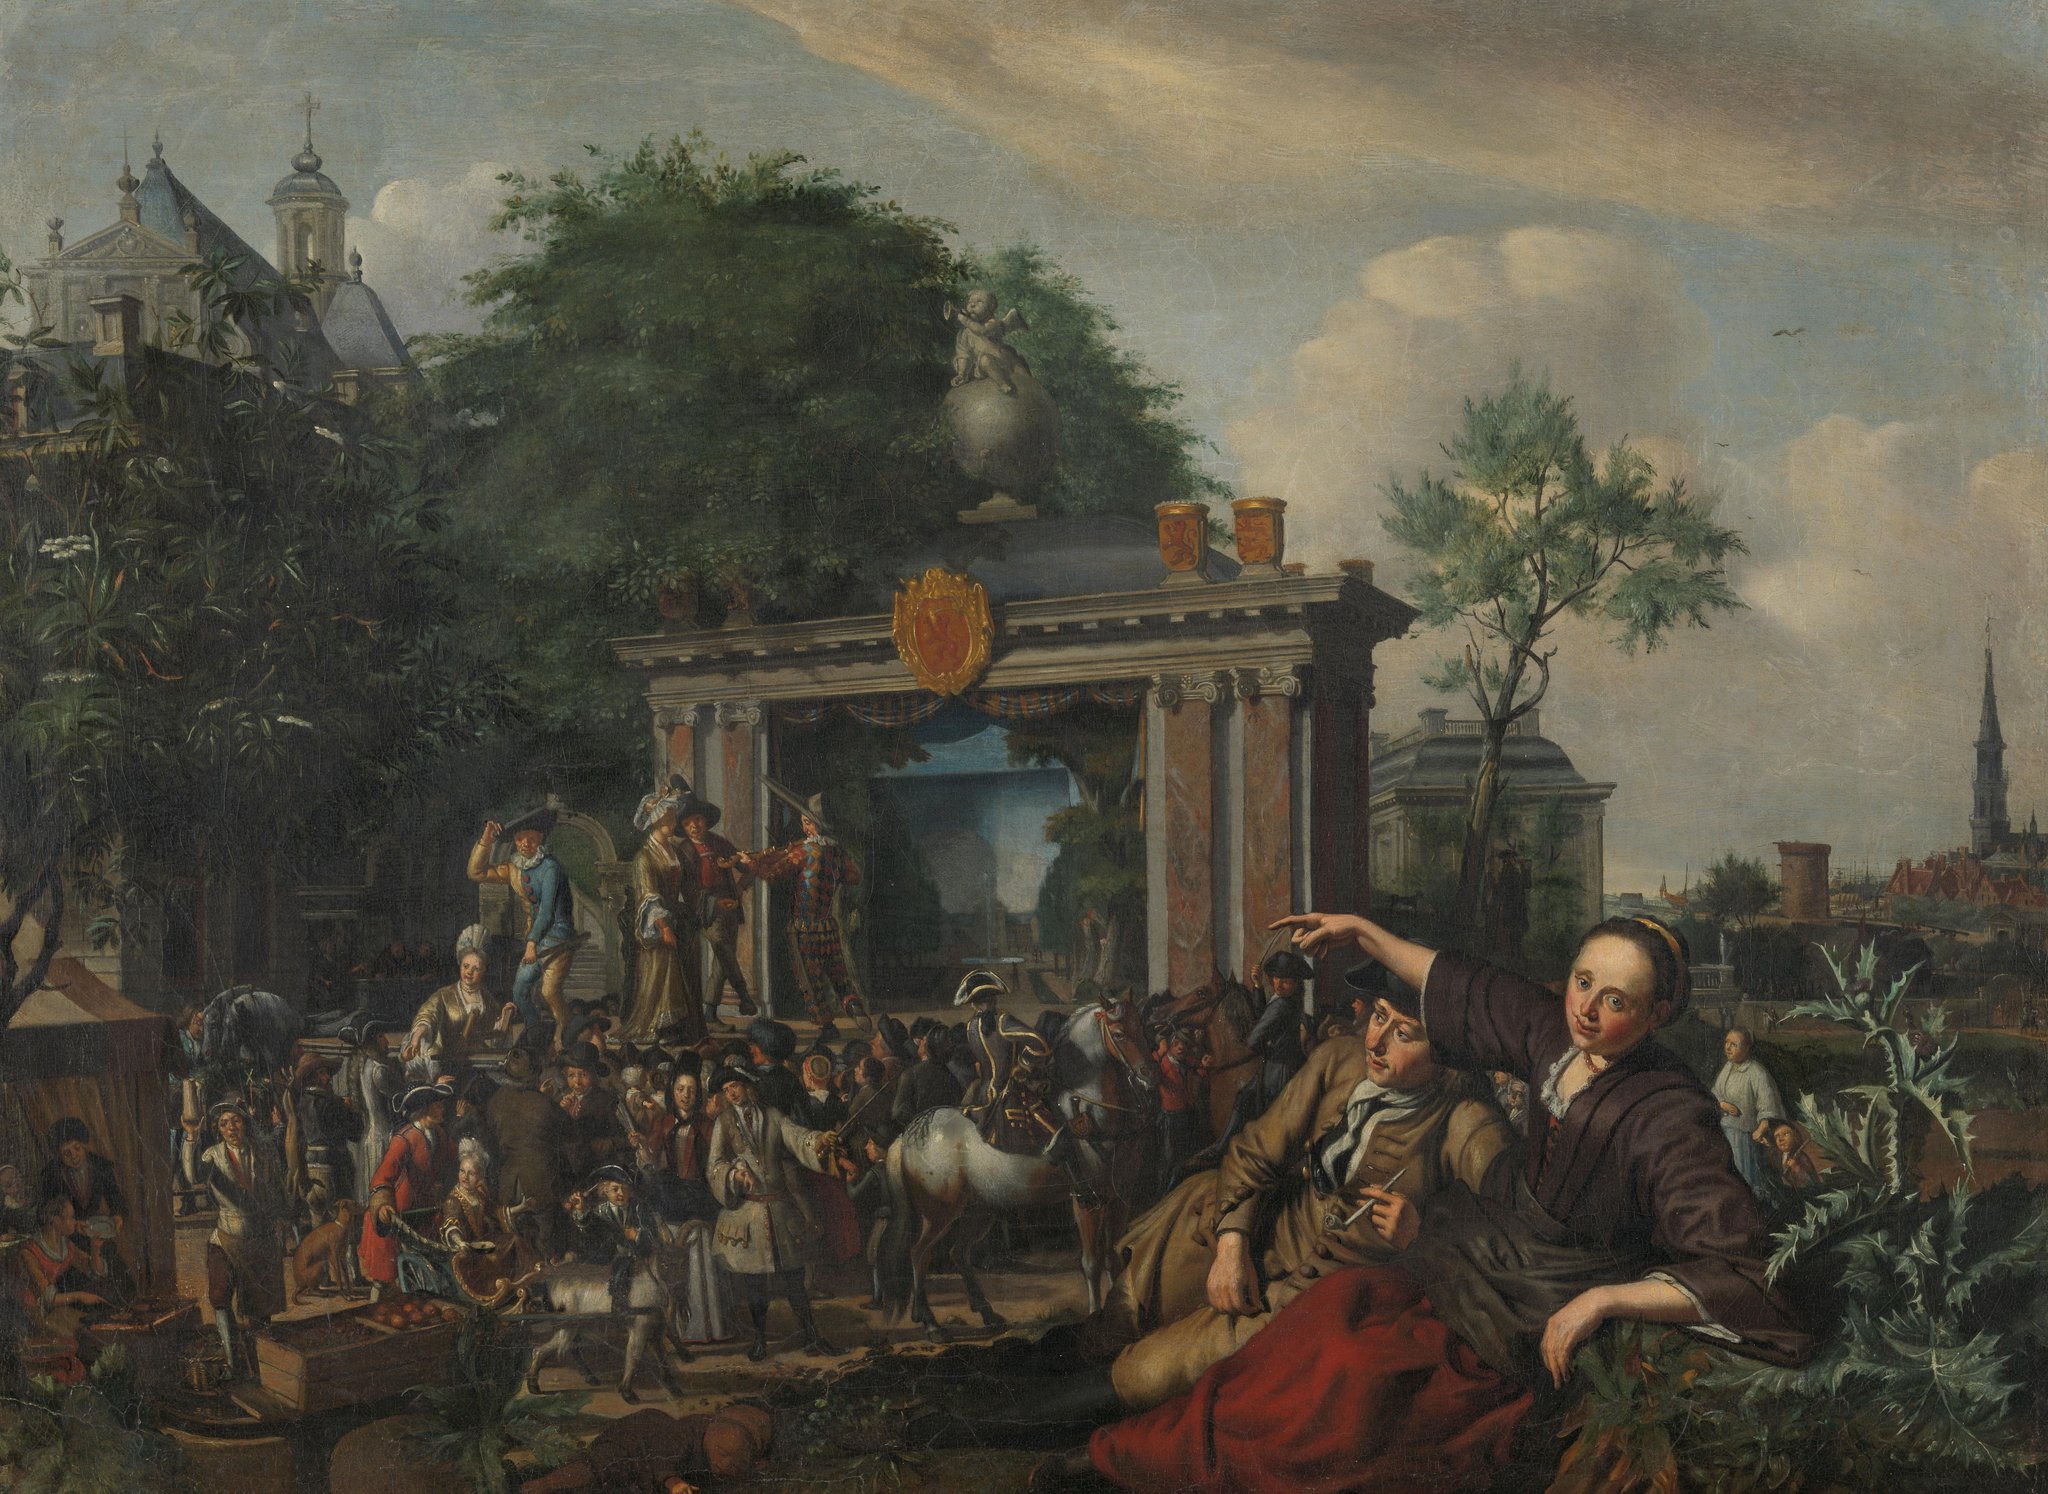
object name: painting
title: Toneelvoorstelling in de open lucht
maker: matthijs naiveu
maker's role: painter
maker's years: 1647-1726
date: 1670-1698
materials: canvas, oil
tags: theatre, theatrical performance, 'commedia dell'arte', theatre (building) - aa - open-air performances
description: Toneelvoorstelling in de open lucht. Rechts op de voorgrond, bij een distel, liggen een man en een vrouw in het gras, zij wijst met de hand naar een toneelvoorstelling. Voor het podium heeft zich een menigte verzameld, links een pannenkoekenbakster, in het midden kinderen met een bokkenwagen, rechts een officier te paard. Op het toneel een dansend paar en een vioolspelende harlekijn. Het toneel is versierd met wapens van de provincies.